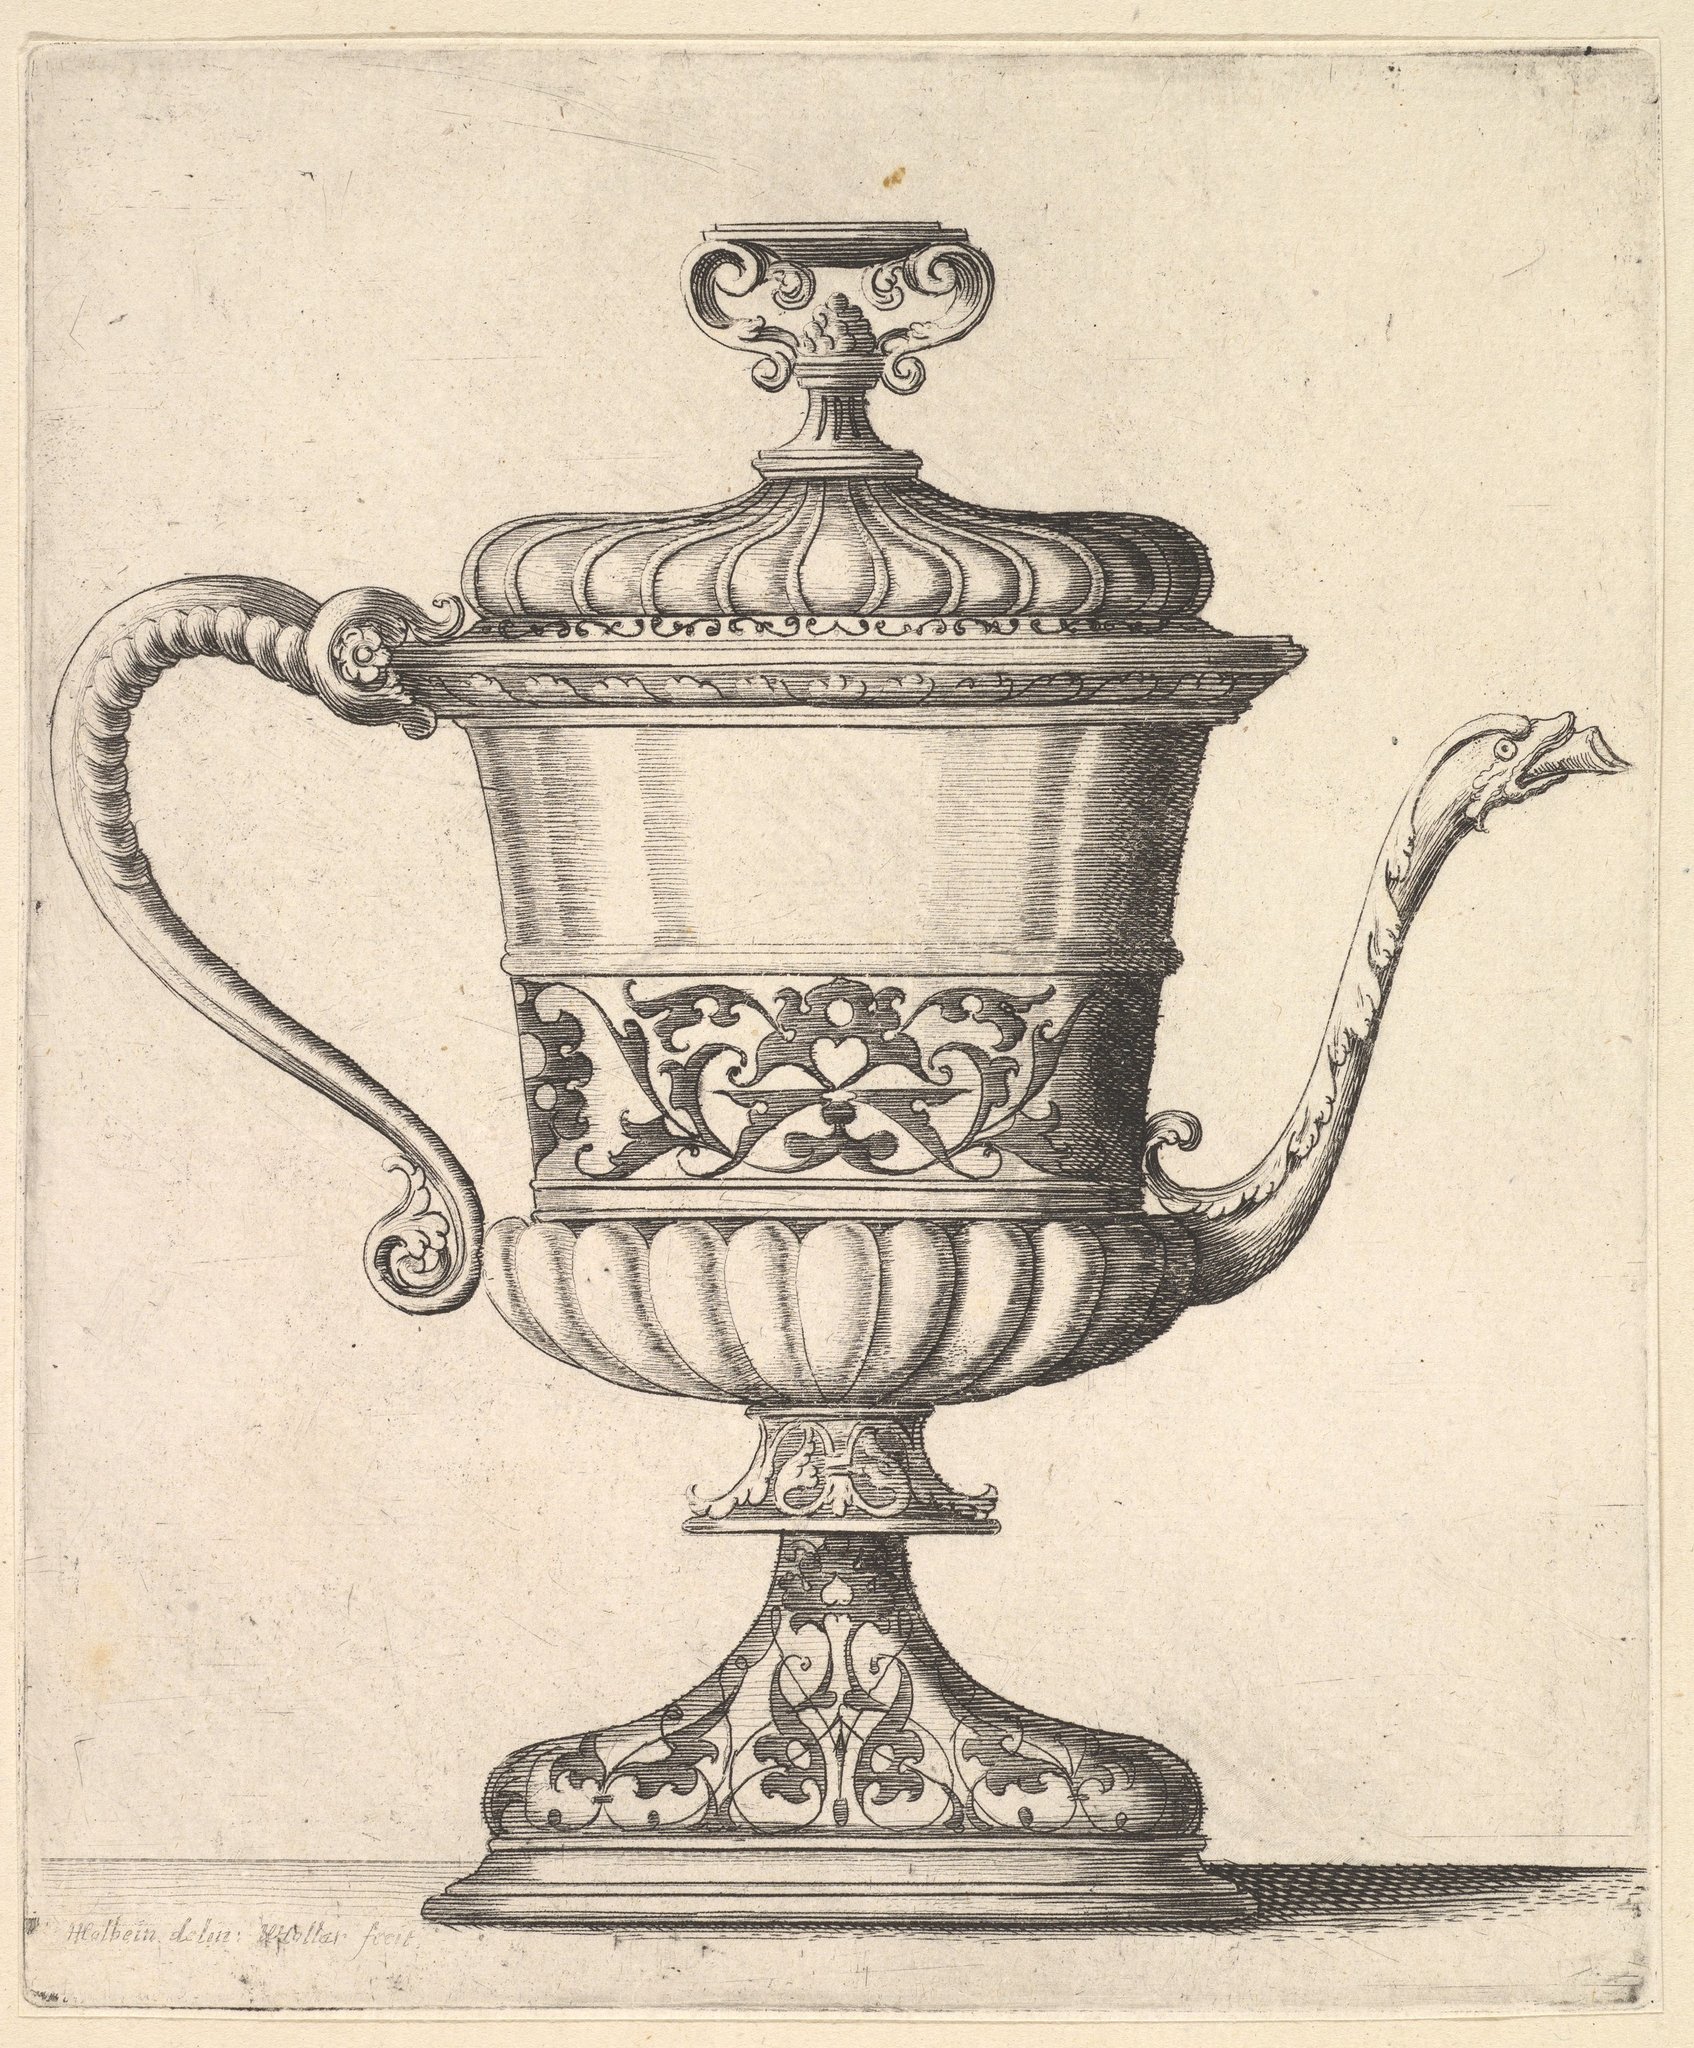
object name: print ornament architecture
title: Jug with lid, engraved with arabesque pattern, the narrow spout to right ending in snake's head, handle to left.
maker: wenceslaus hollar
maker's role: artist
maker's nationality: bohemian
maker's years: 1607-1677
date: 1649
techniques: drypoint, etching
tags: snakes,jugs